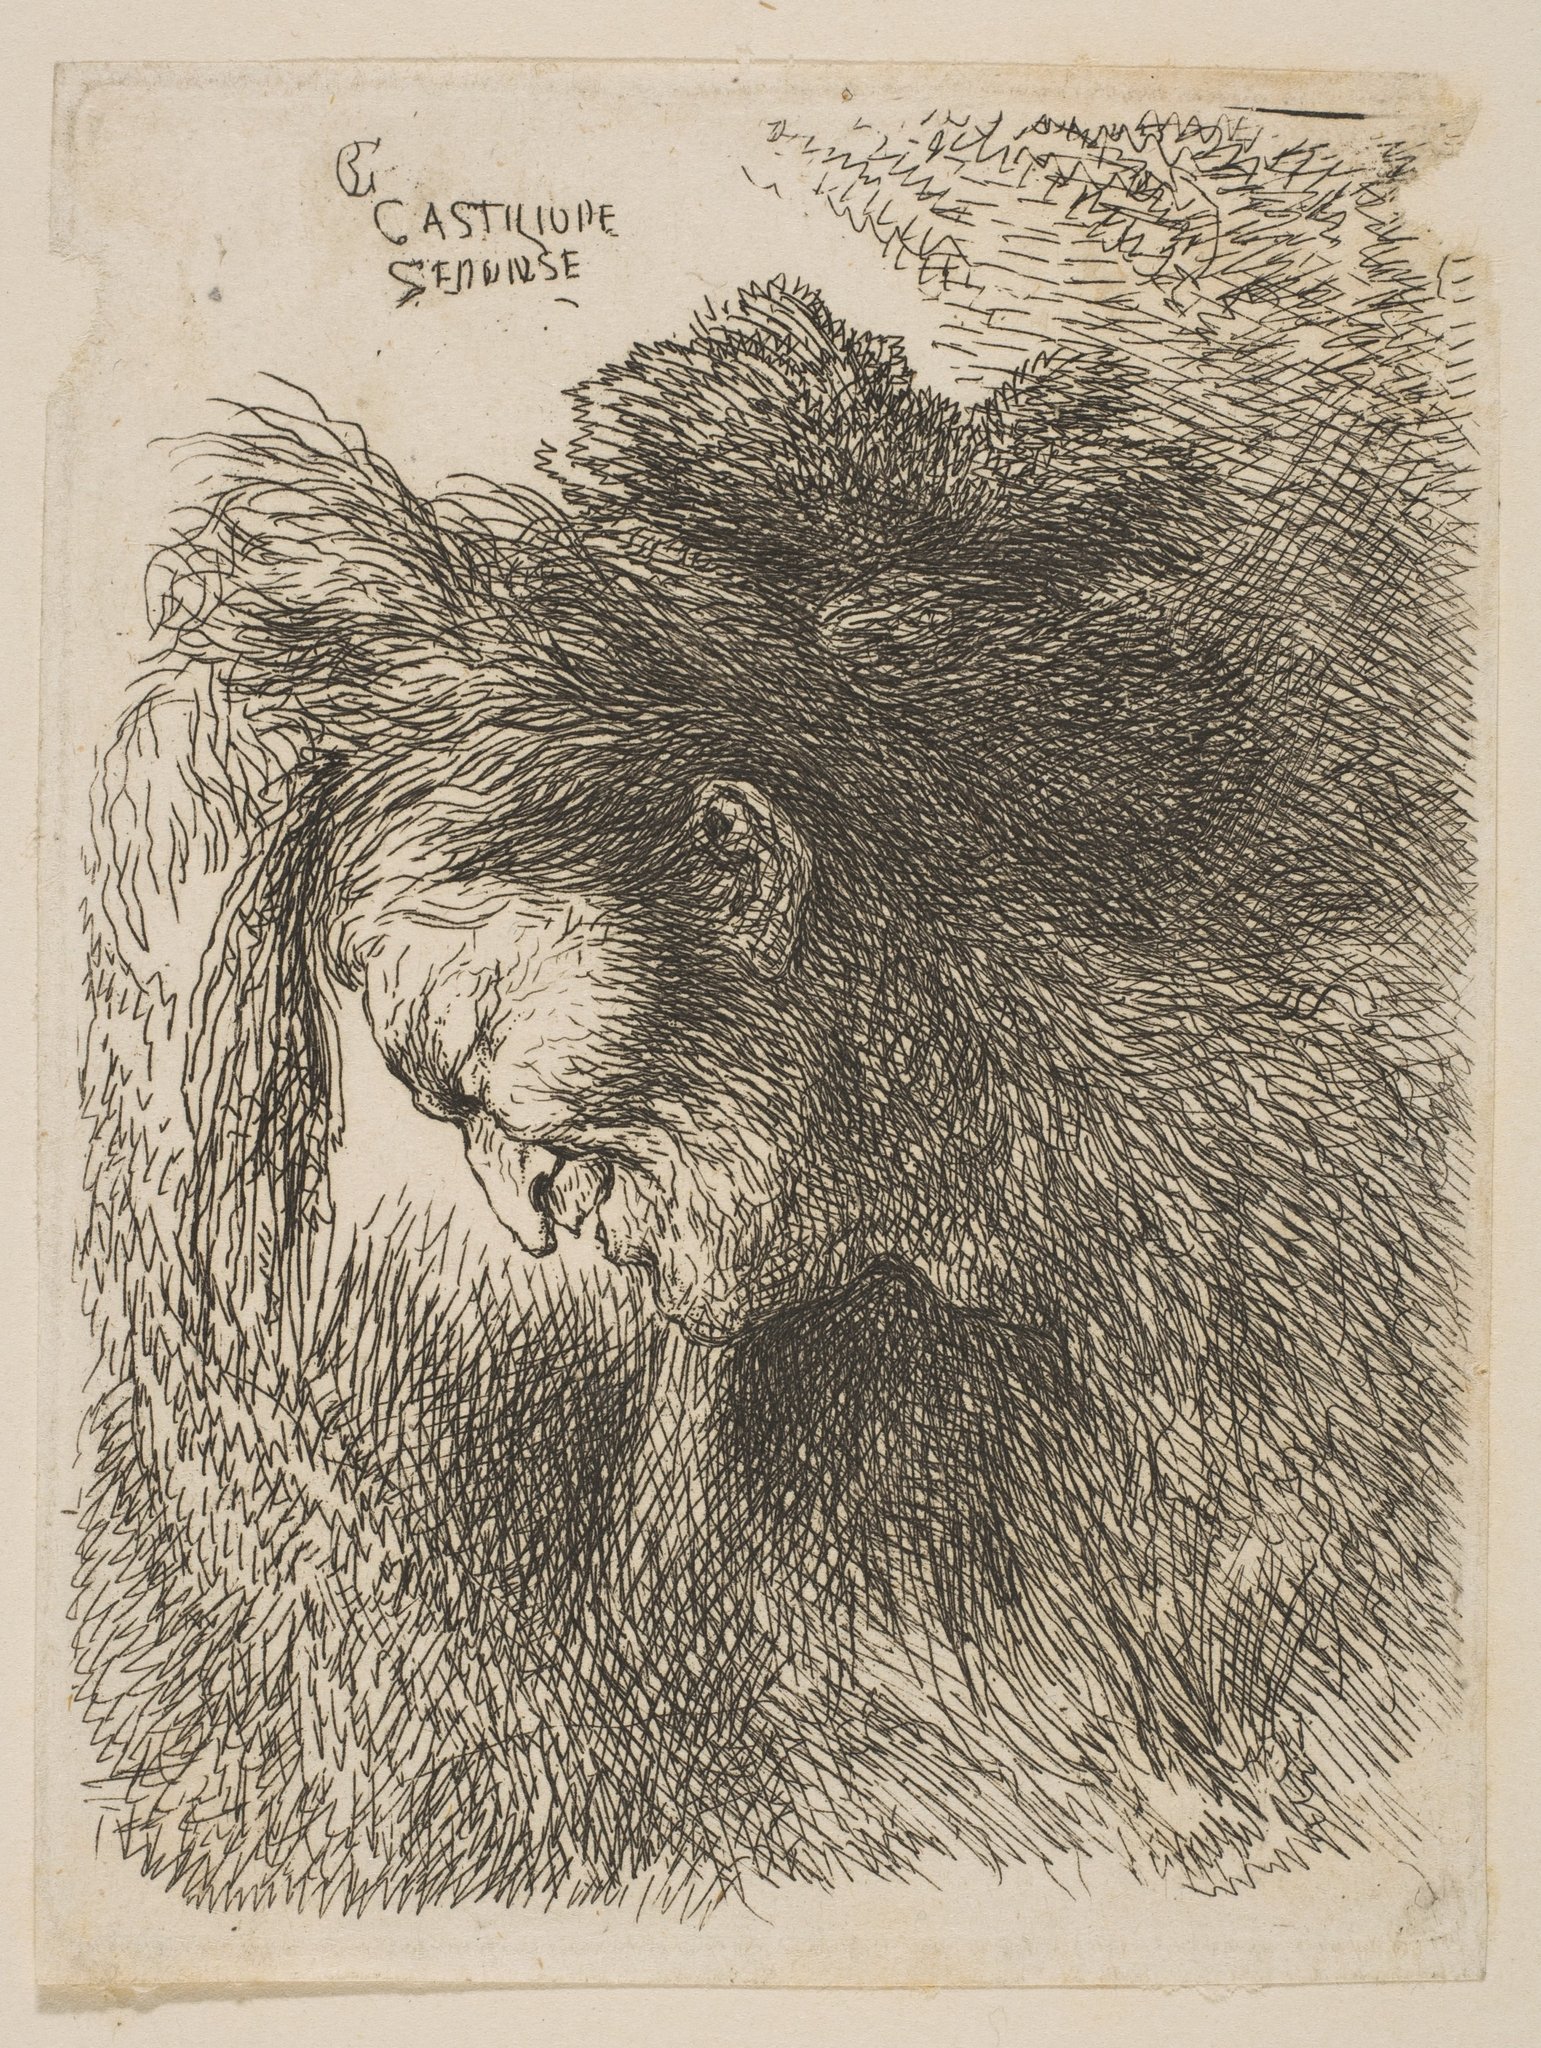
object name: print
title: Head of an old man looking down, facing left, from "Small Studies of Heads in Oriental Headress"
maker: giovanni benedetto castiglione (il grechetto)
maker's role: artist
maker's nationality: italian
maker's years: 1609-1664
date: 1645-1650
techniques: etching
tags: heads,men,profiles